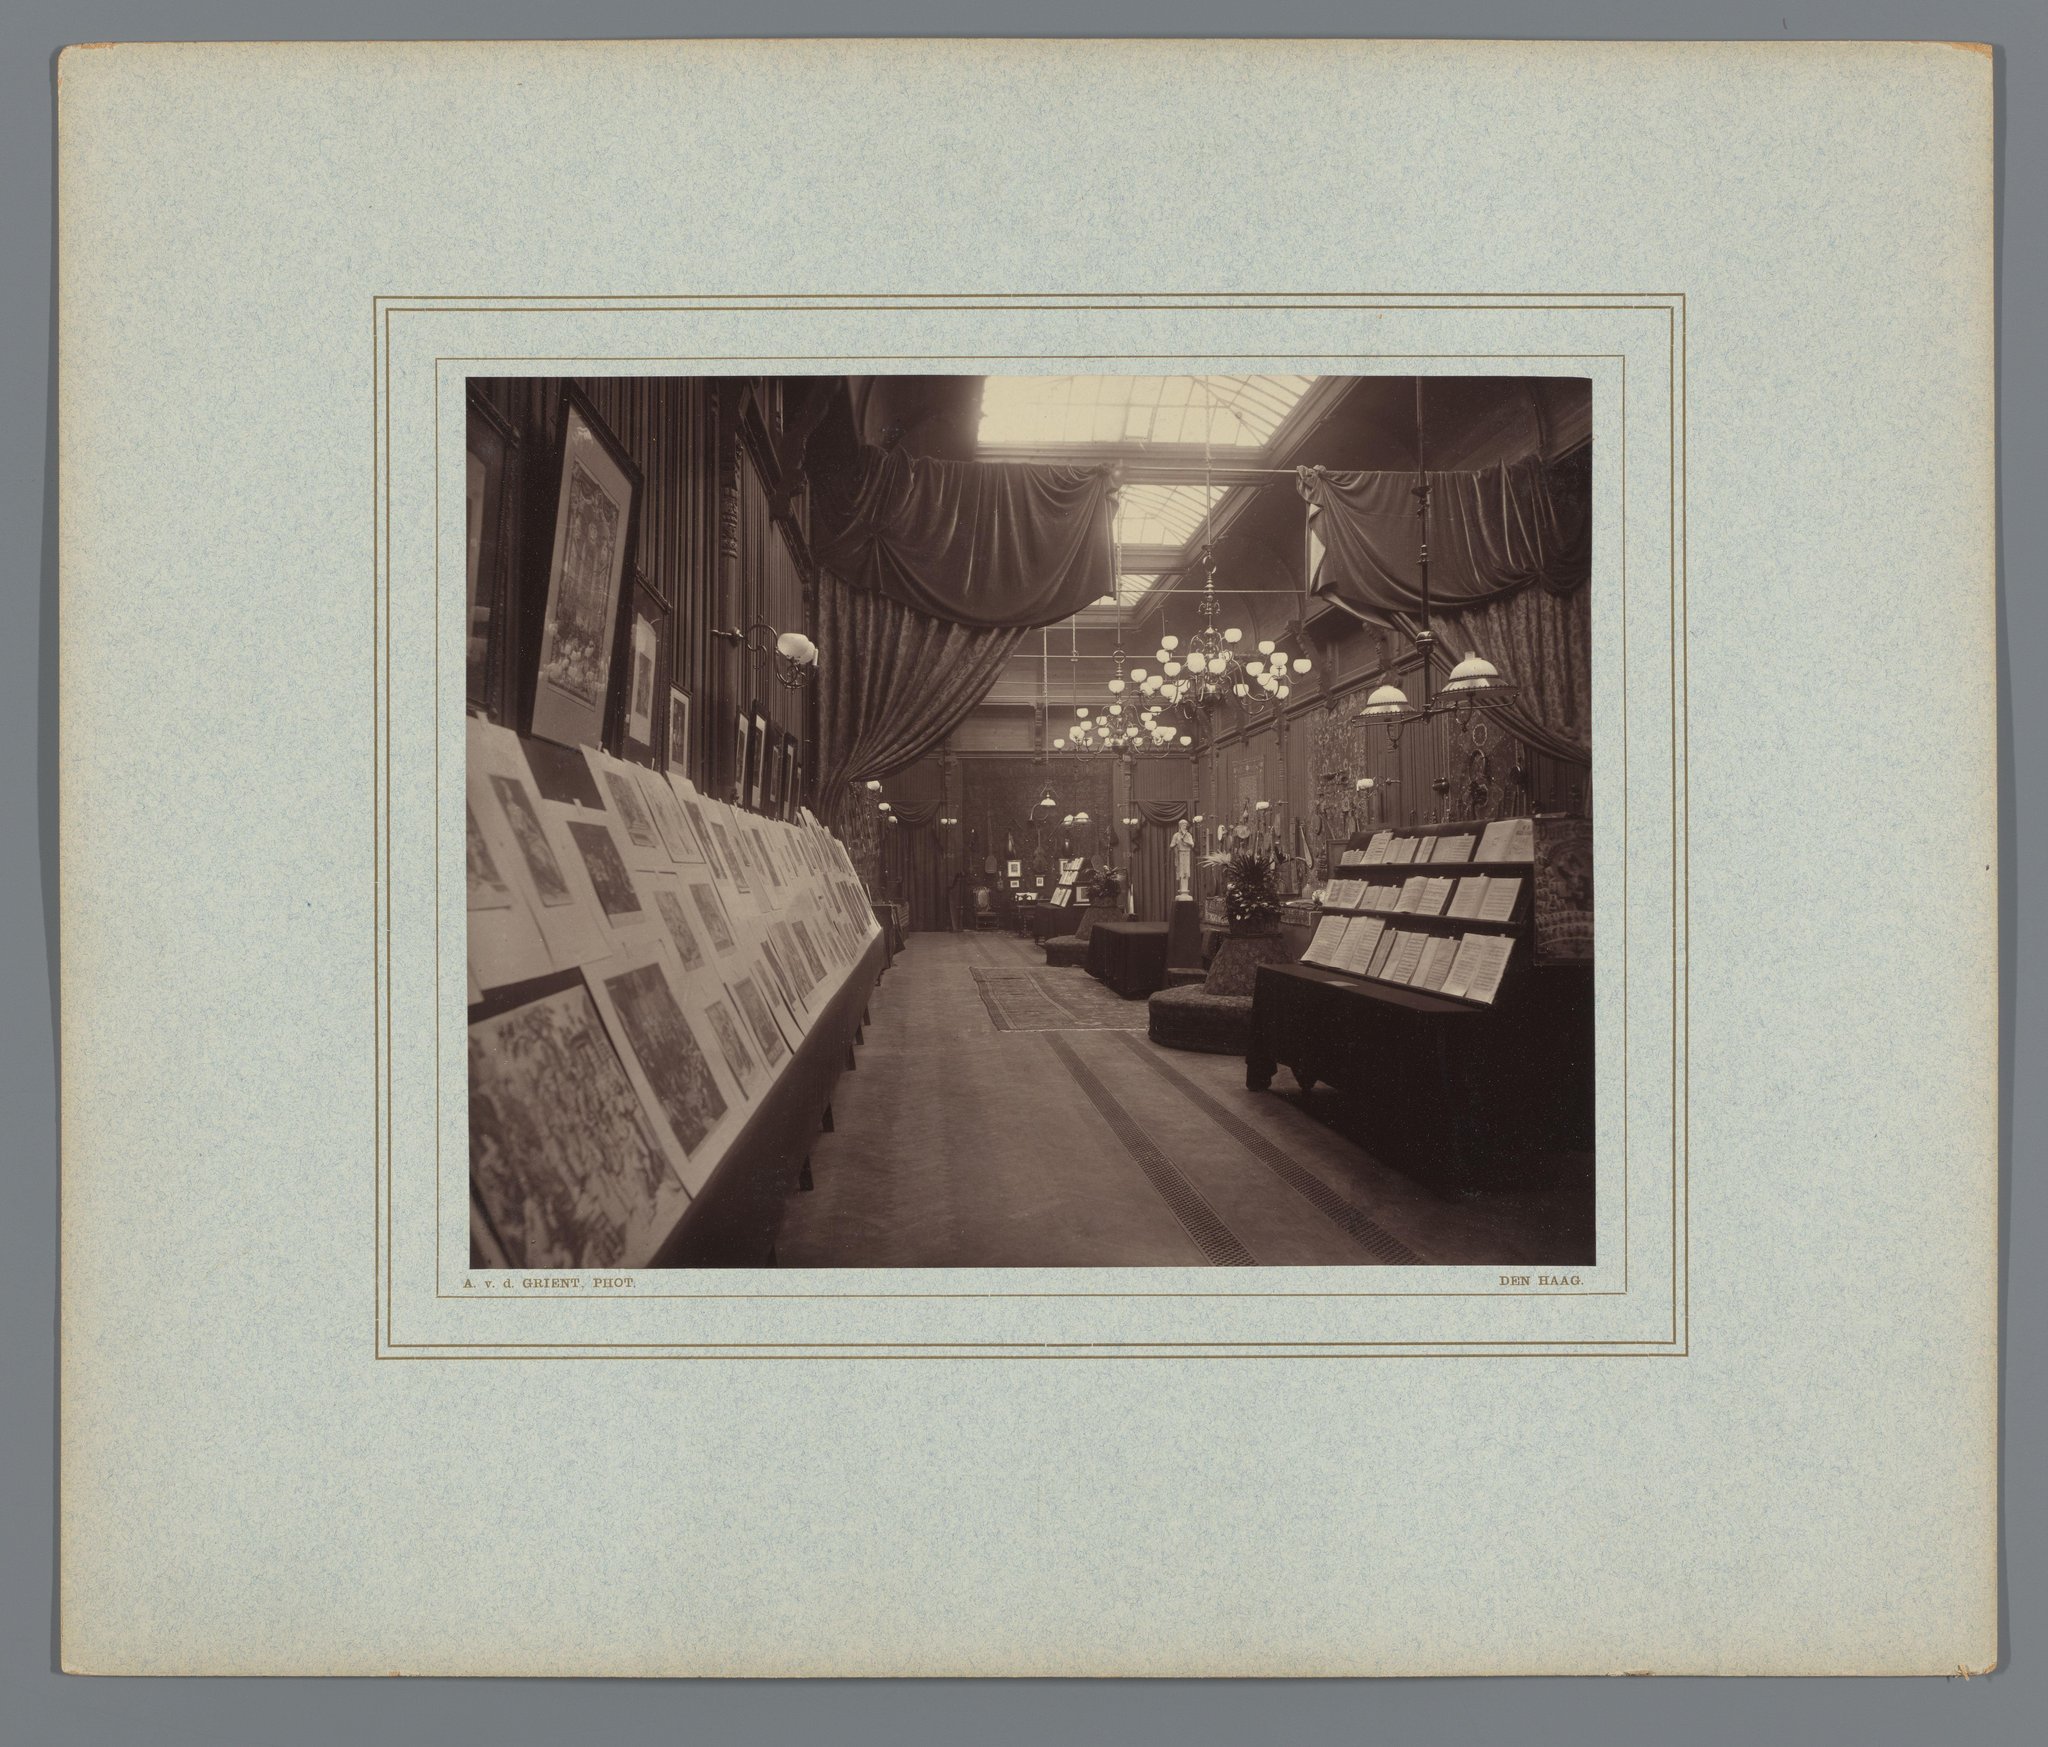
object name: photomechanical print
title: Prenten en bladmuziek uit de collectie Daniël François Scheurleer, tentoongesteld in Pulchri Studio in 1893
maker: adrianus van der grient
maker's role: fotograaf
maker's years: 1858-1941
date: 1893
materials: cardboard, paper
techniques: woodburytype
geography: pulchri studio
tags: the hague, daniël françois lunsingh scheurleer, printed edition of musical score, printing ~ applied arts, exhibition ~ art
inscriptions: inscription: ‘A. v. d. GRIENT, PHOT. - DEN HAAG.’